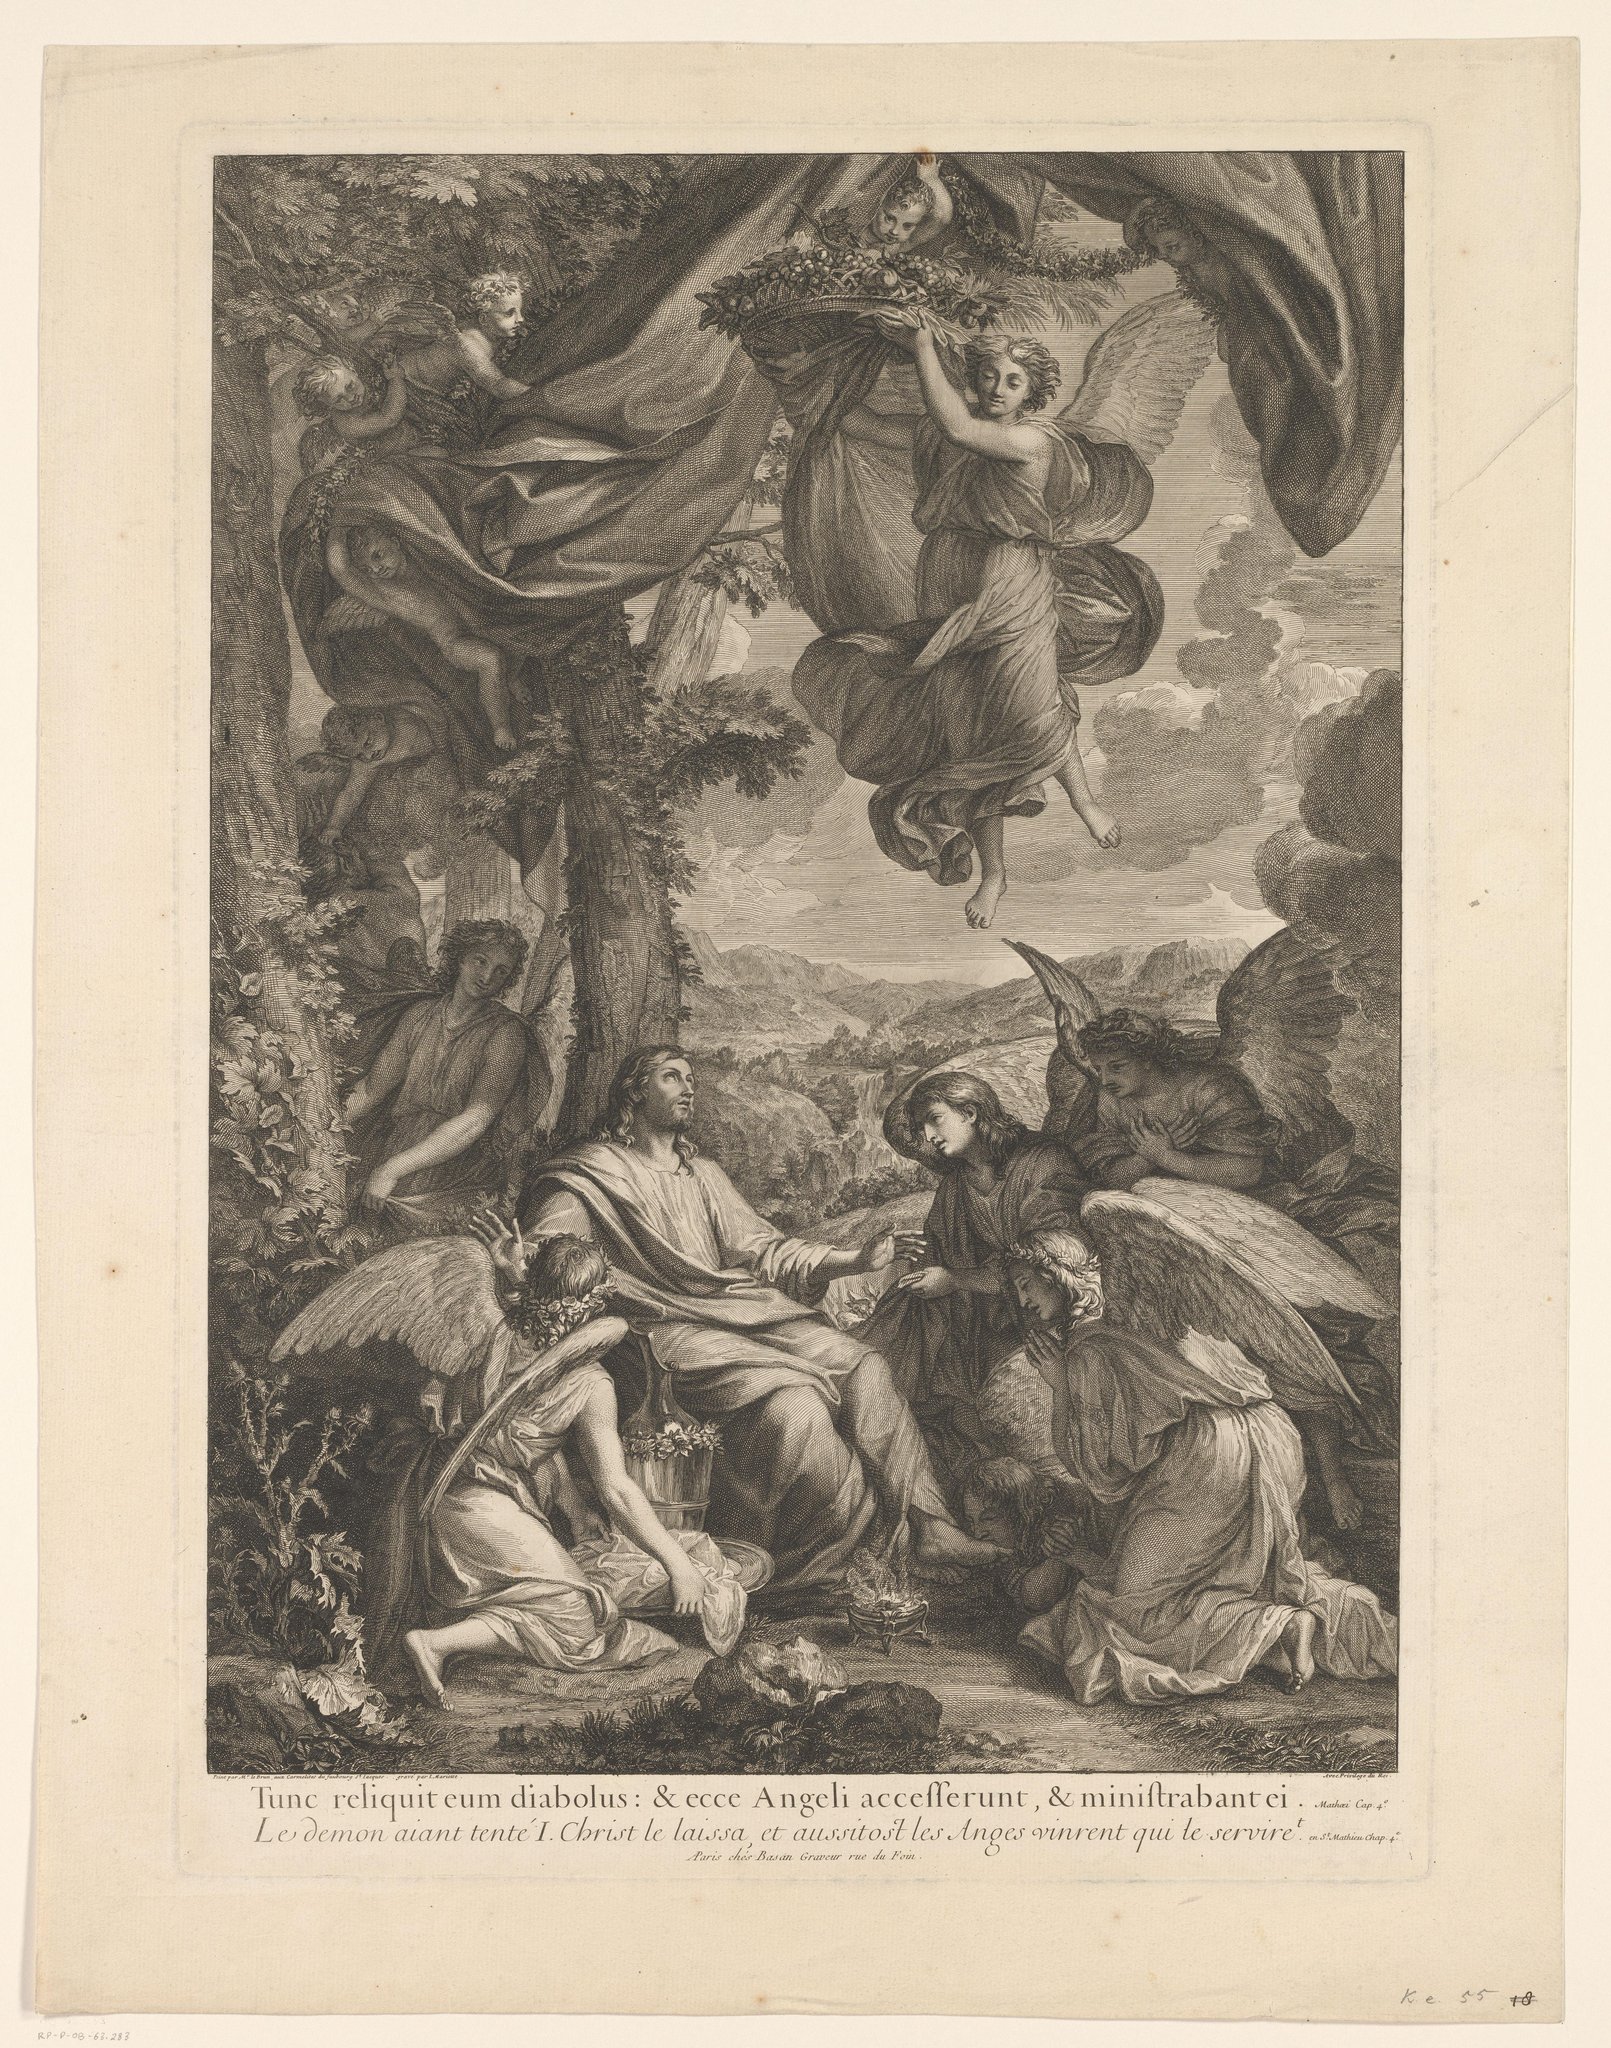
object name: print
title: Christus door de engelen verzorgd na de verzoeking van de duivel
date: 1670-1742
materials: paper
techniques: engraving, etching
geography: france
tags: christ ministered by angel(s): they bring water and food, sometimes sent by mary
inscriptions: collector's mark: Lugt 2165